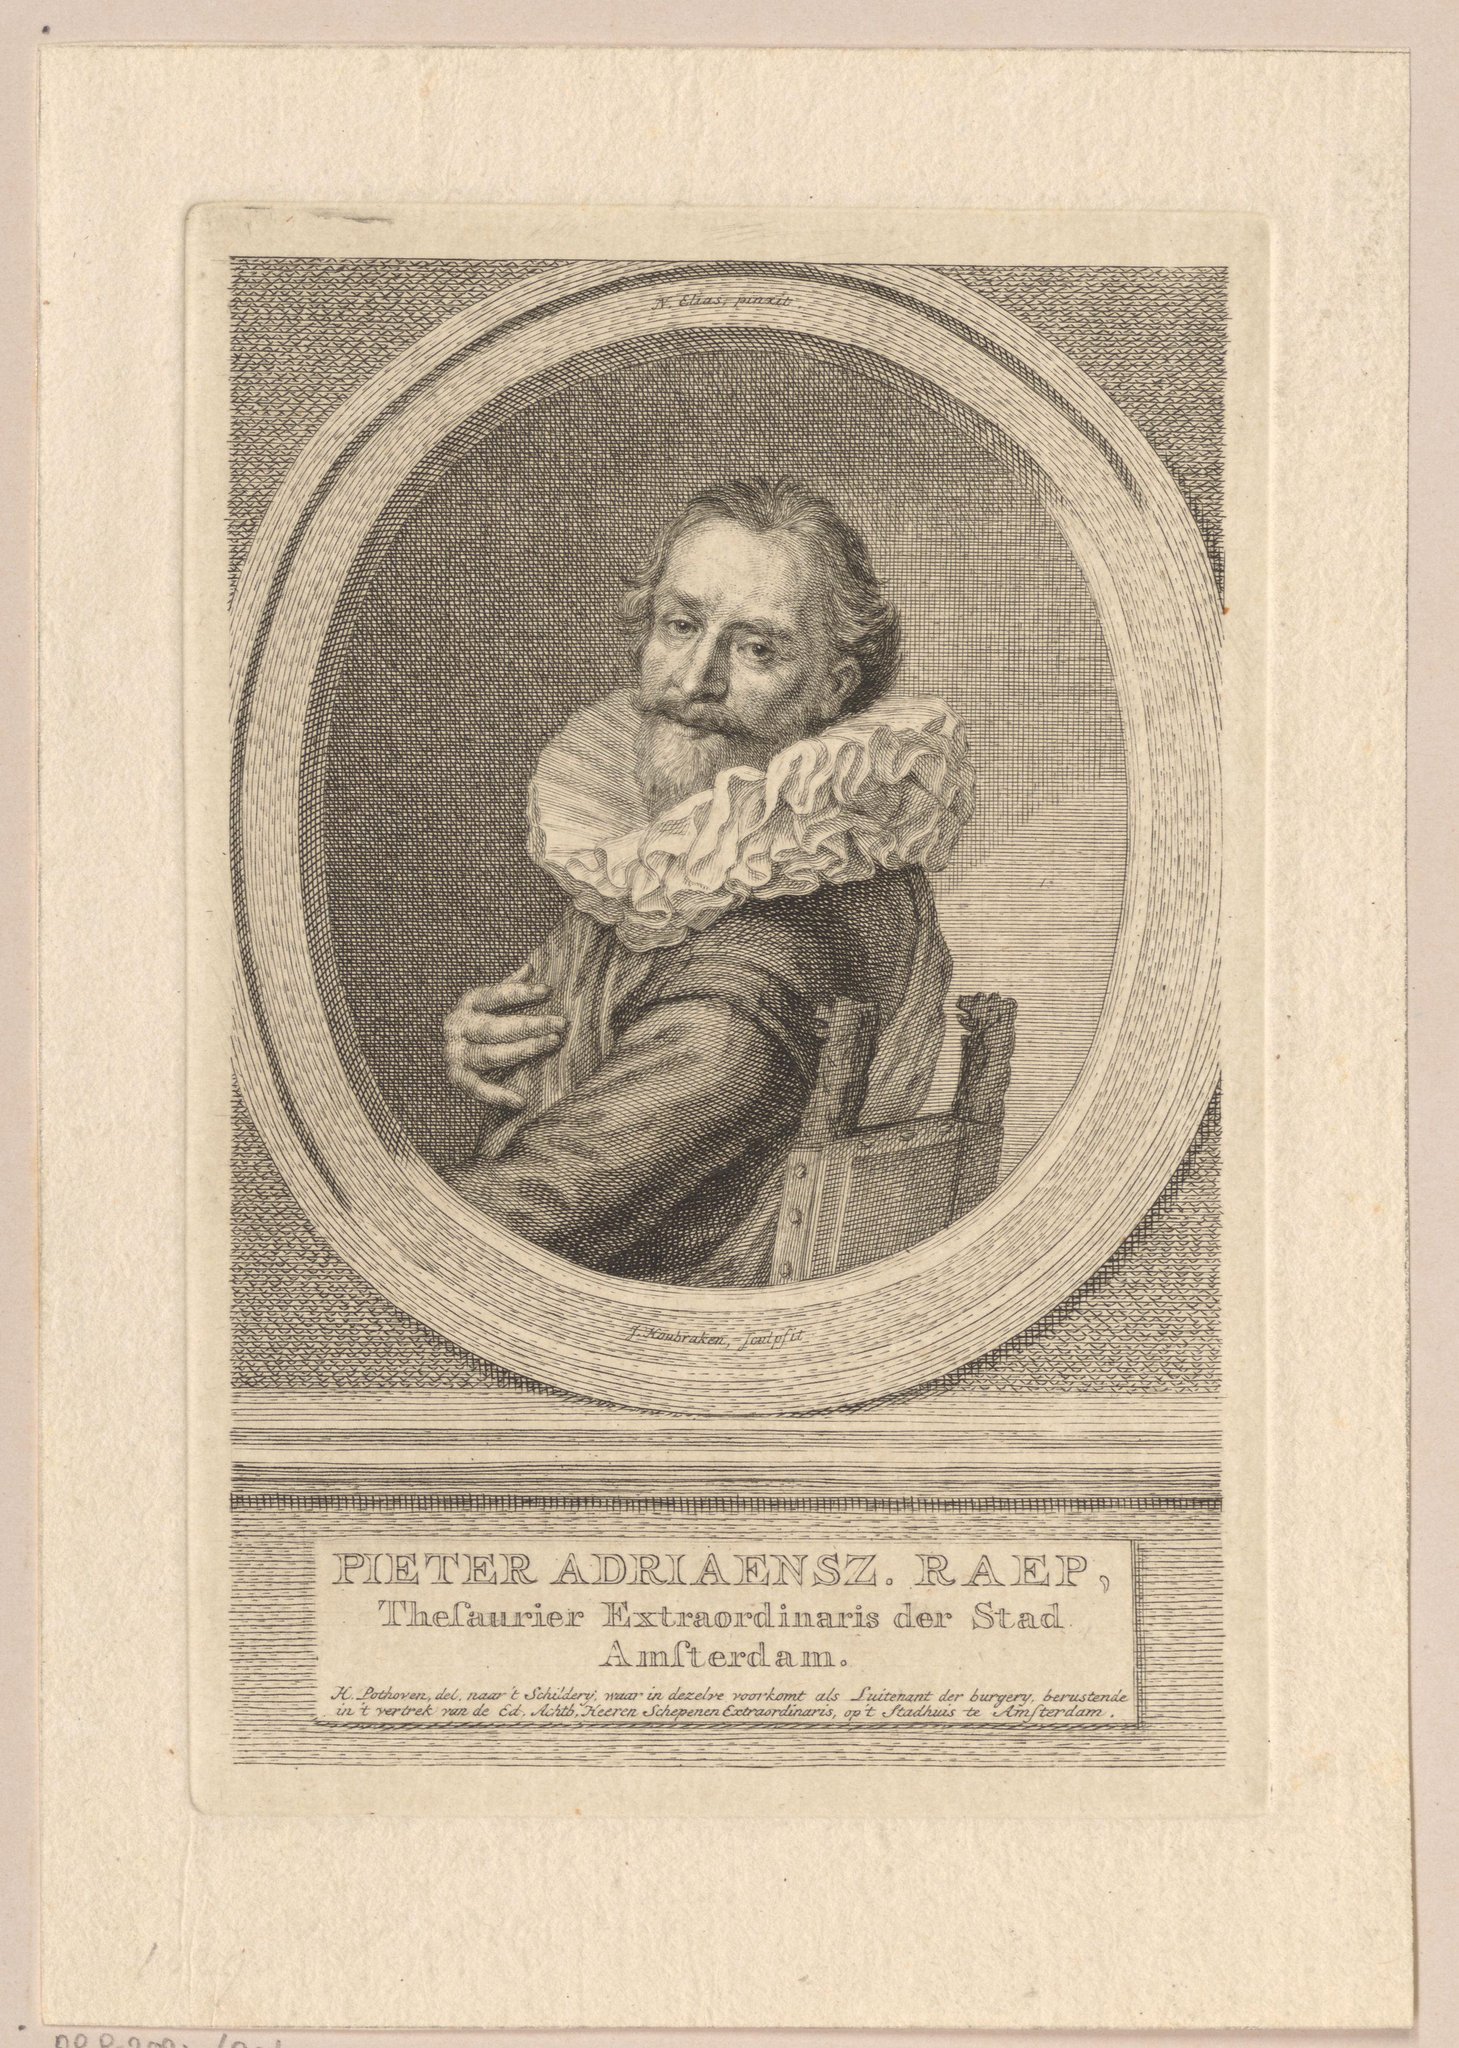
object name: print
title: Portret van Pieter Adriaenz. Raep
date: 1710-1780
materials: paper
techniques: engraving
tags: historical persons